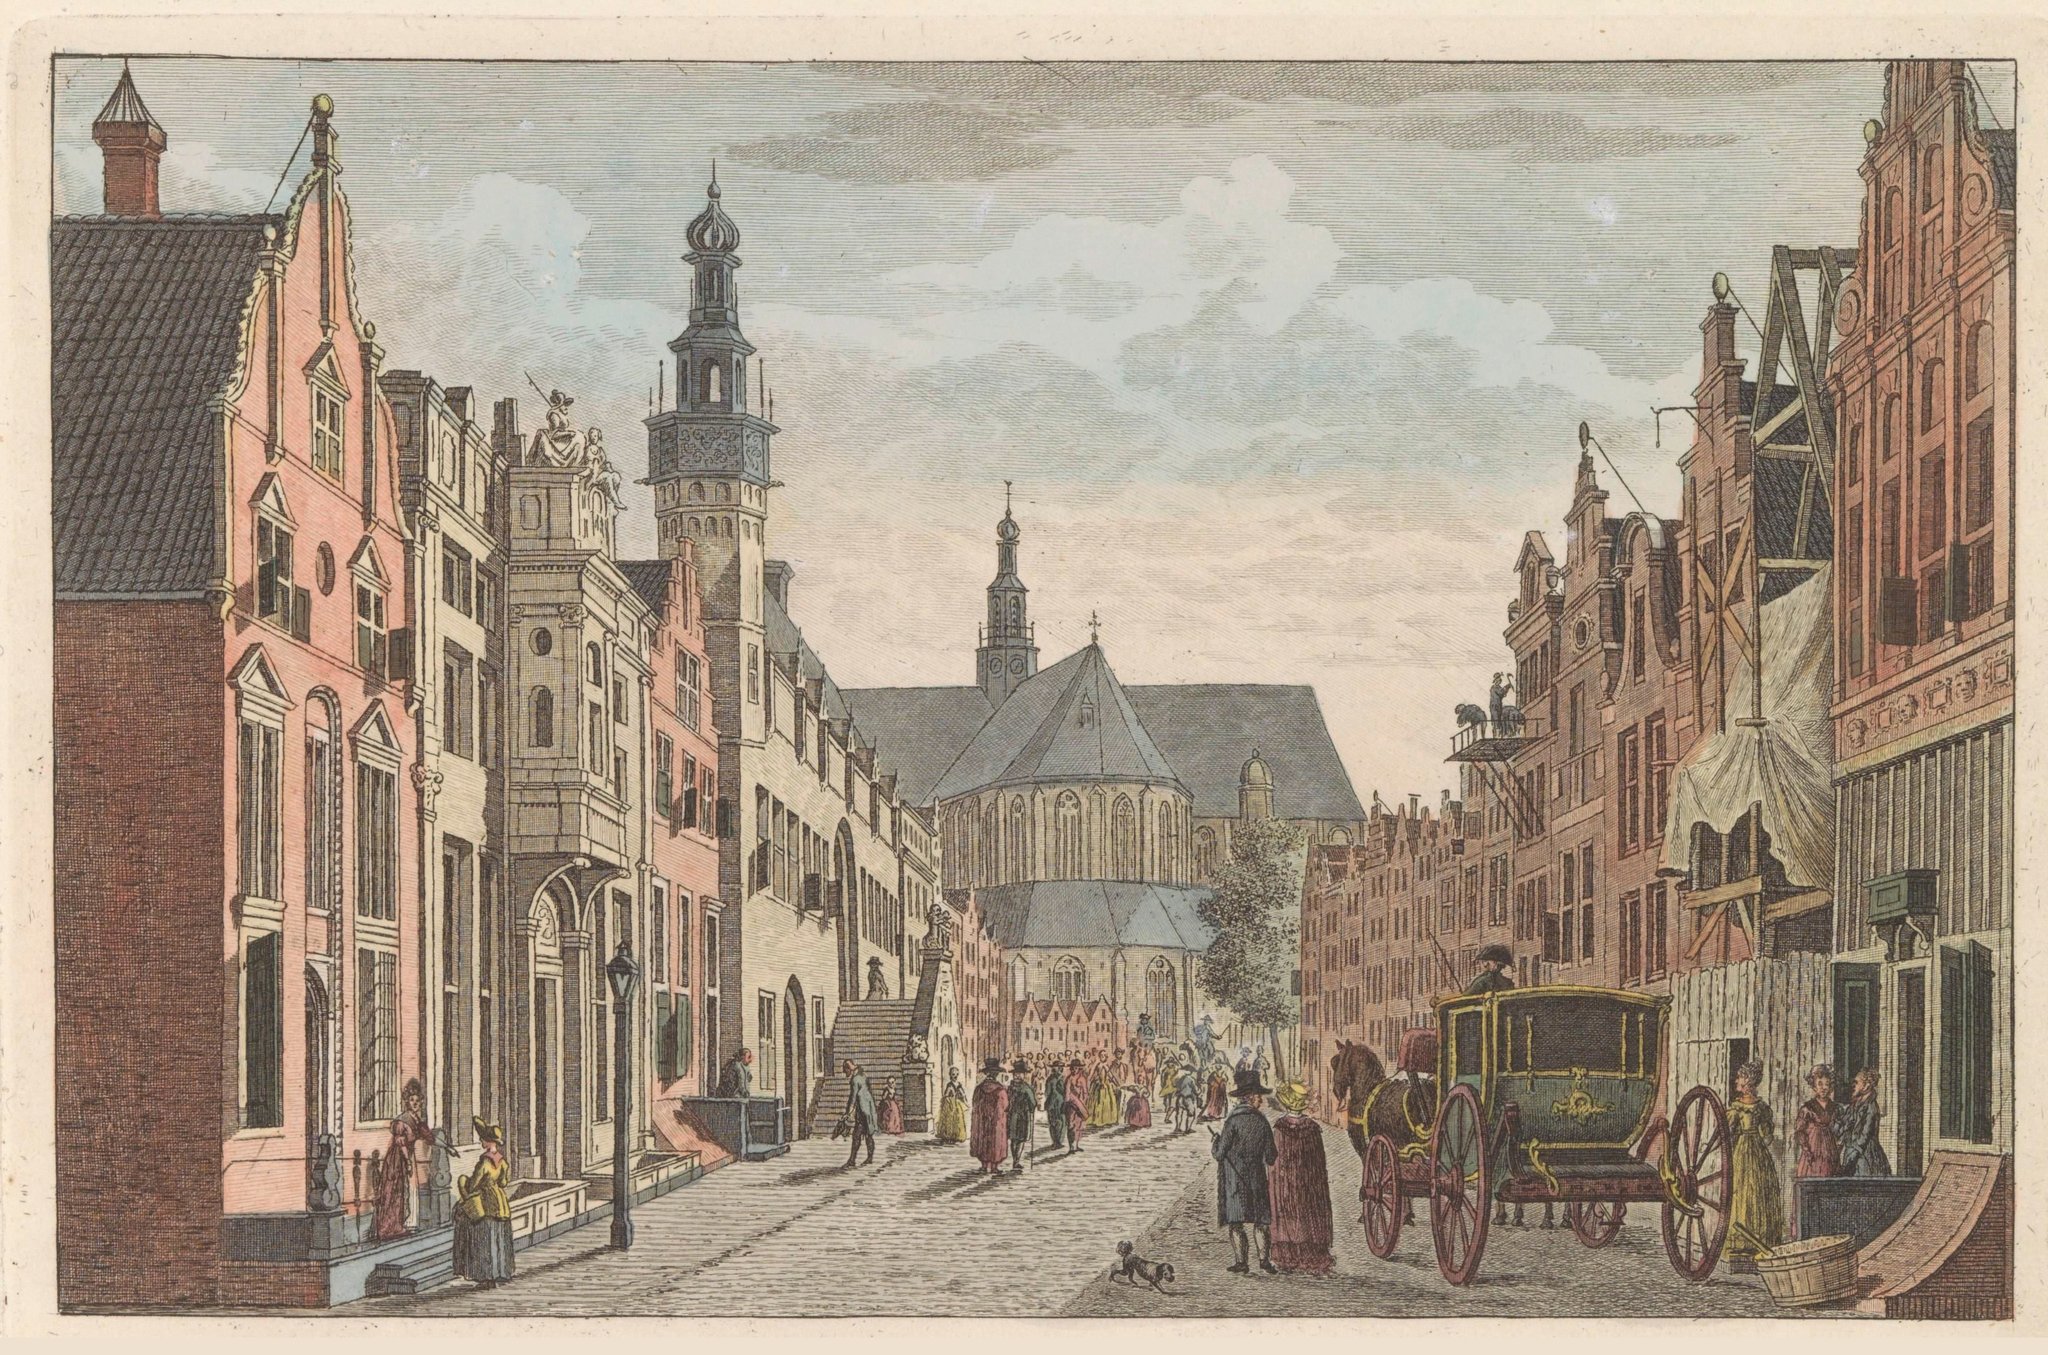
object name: print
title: Langestraat te Alkmaar, ca. 1790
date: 1786-1792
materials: paper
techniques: engraving, etching, hand coloring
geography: netherlands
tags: stadhuis, alkmaar, grote of sint-laurenskerk, langestraat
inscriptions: inscription: ‘chez E: Maaskamp à Amsterdam’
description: Huidige staat van prent uitgegeven als onderdeel van een plaatwerk uit ca. 1824-1825 met 74 (ongenummerde) platen van de belangrijkste topografische gezichten en verschillende zeden en gewoonten in het Verenigd Koninkrijk der Nederlanden, getiteld 'Tableau des principales vues des palais et édifices : représentations et des coutumes et usages, dans les provinces septentrionales du Royaume des Pays-Bas'. Eerdere staat gebruikt in: Vaderlandsche gezichten, of afbeeldingen van den tegenwoordigen staat der Vereenigde Nederlanden (…). Amsterdam: Hendrik Gartman, Willem Vermandel en Jan Willem Smit, 1786-1792. Uitgegeven in afleveringen met ieder een eigen bifolium en inhoudsopgave. Alle prenten in deze publicatie zijn gegraveerd door Carel Frederik Bendorp (I) en, in de meeste gevallen, gebaseerd op tekeningen van Jan Bulthuis.